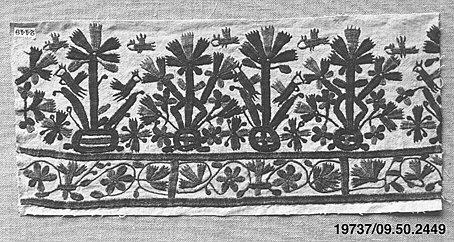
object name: fragment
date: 1701-1800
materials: linen, silk